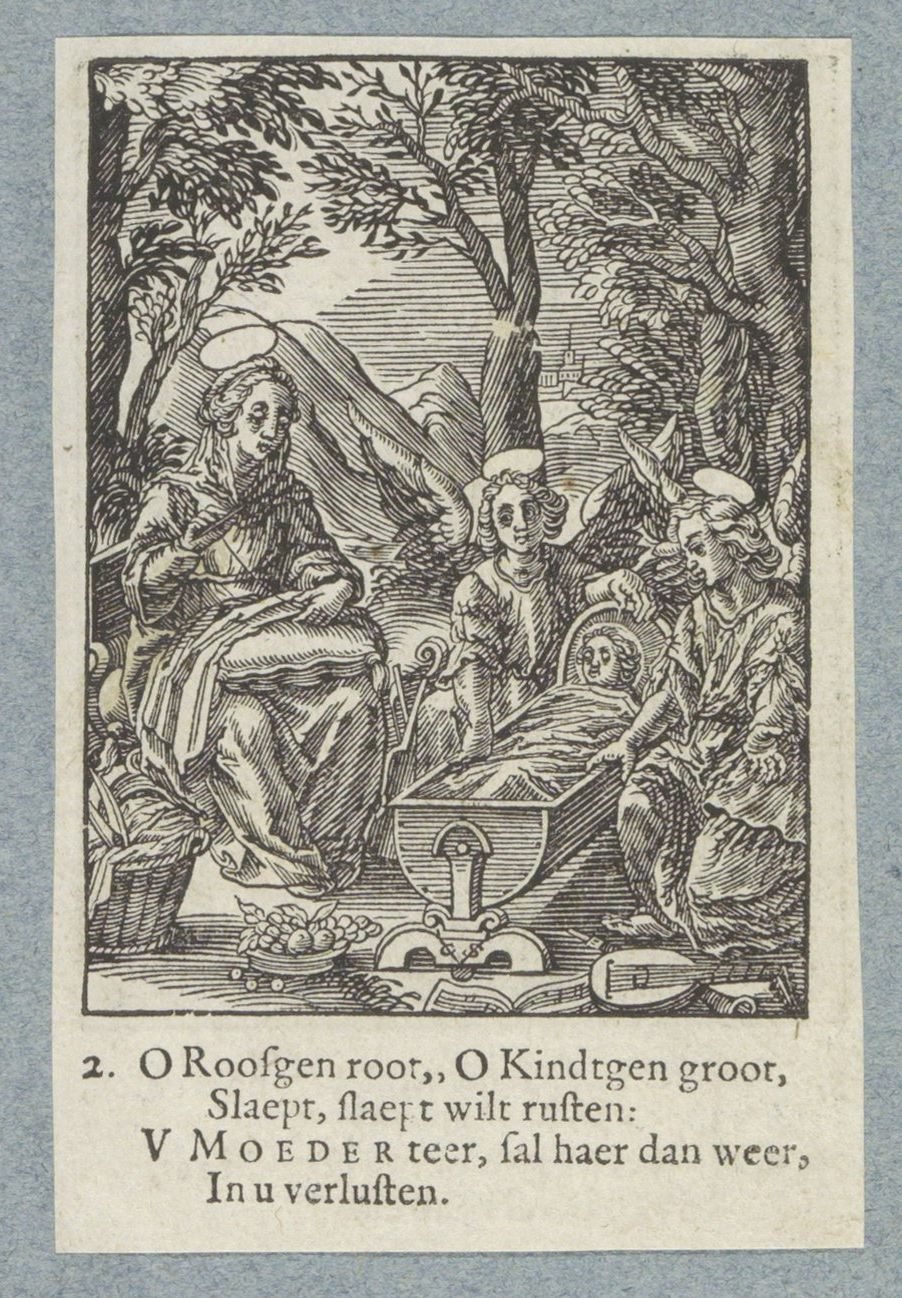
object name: print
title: Christuskind slaapt in de wieg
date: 1617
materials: paper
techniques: letterpress printing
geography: amsterdam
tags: cradle, crib, angels, household occupations of mary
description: De prent verscheen in 1617 bij J.P. Paets als onderdeel van de serie over de jeugd van Christus. Daarnaast werd de houtsnede gebruikt in: Der Zielen Lust-hof. Leuven, I.Jacbosz voor P.J. Paets [= Amsterdam, P.J. Paets], 1629; Bibels Tresoor ofte der zielen lusthof. Amsterdam, P.J. Paets, 1646 en tSchat der Zielen. Amsterdam, P.J. Paets, 1648.